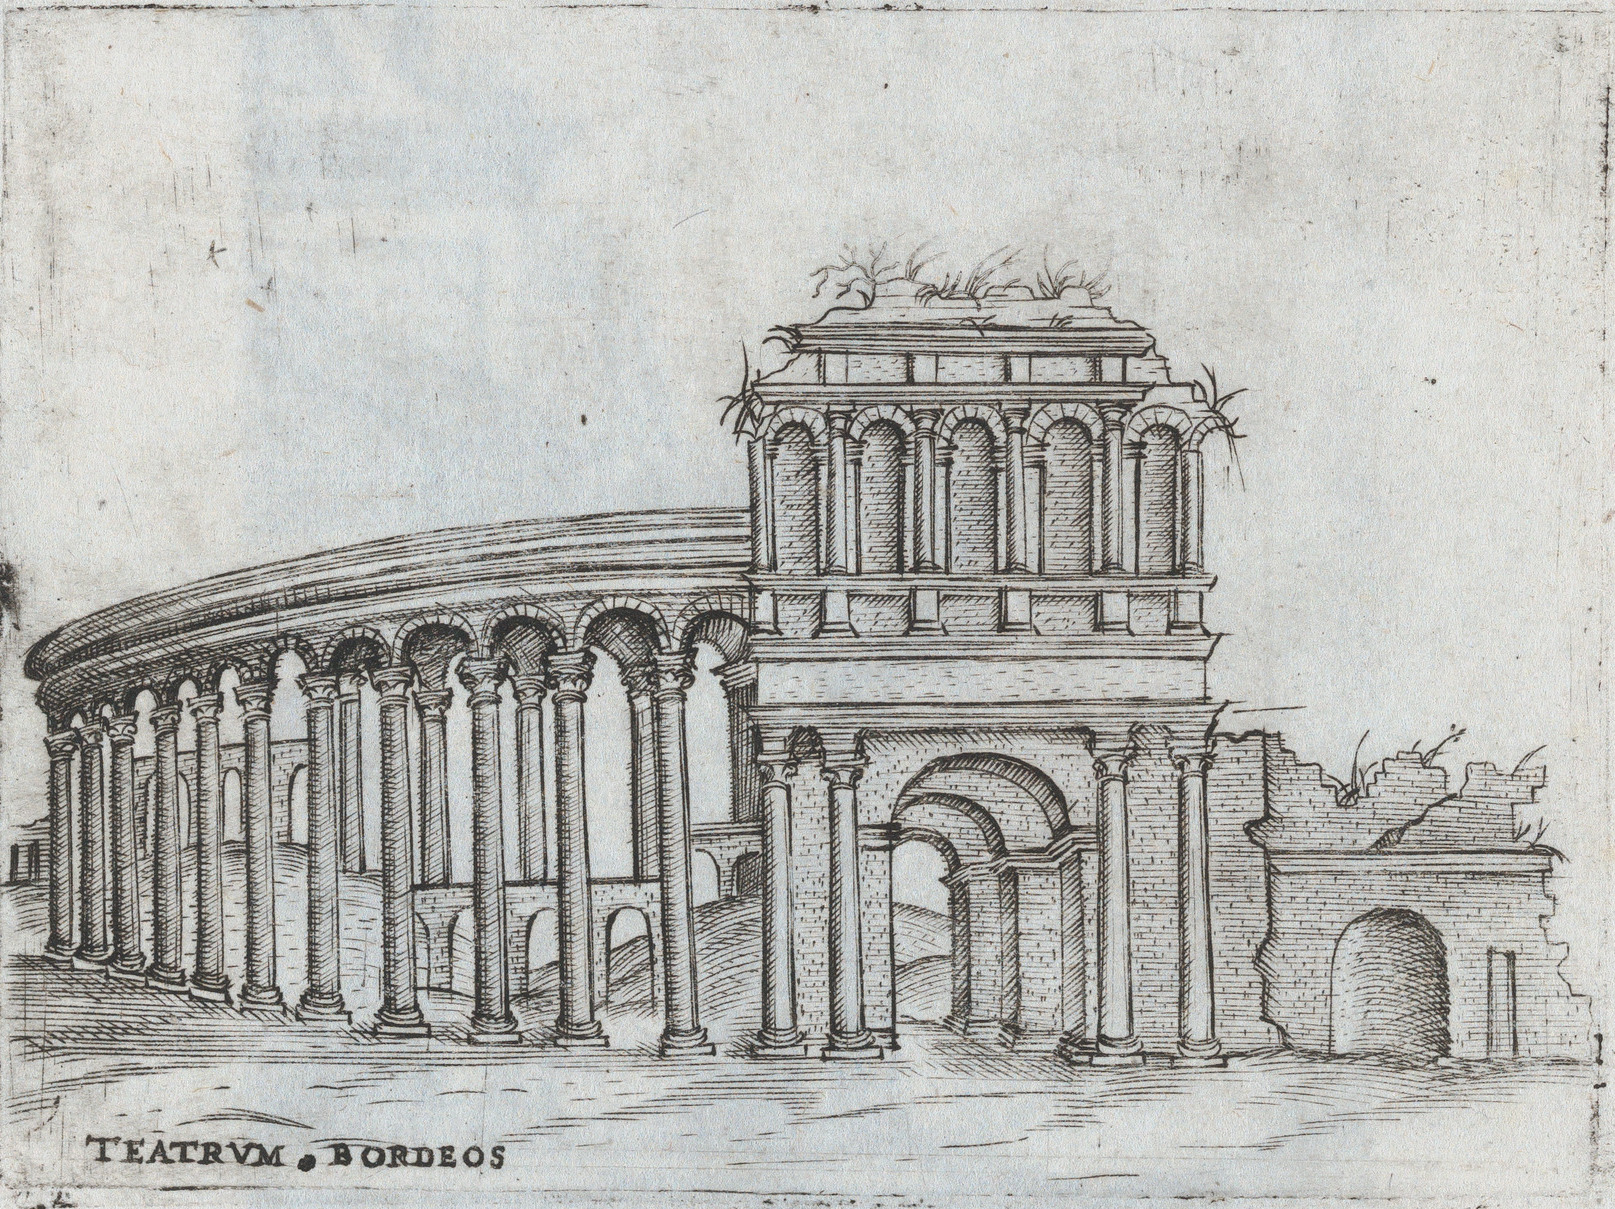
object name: album print ornament architecture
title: Tenplum Iovis Ultoris, from a Series of Prints depicting (reconstructed) Buildings from Roman Antiquity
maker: monogrammist g.a. with the caltrop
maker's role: artist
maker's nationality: italian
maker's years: 1535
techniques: engraving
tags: architecture,arches,ruins